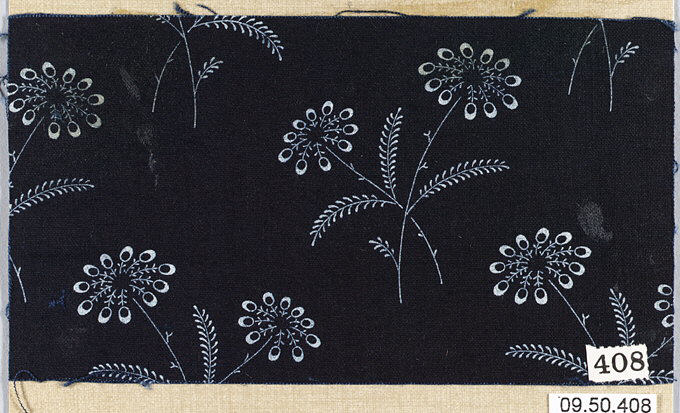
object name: piece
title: Piece (one of 116)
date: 1801-1900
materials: cotton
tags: flowers,leaves